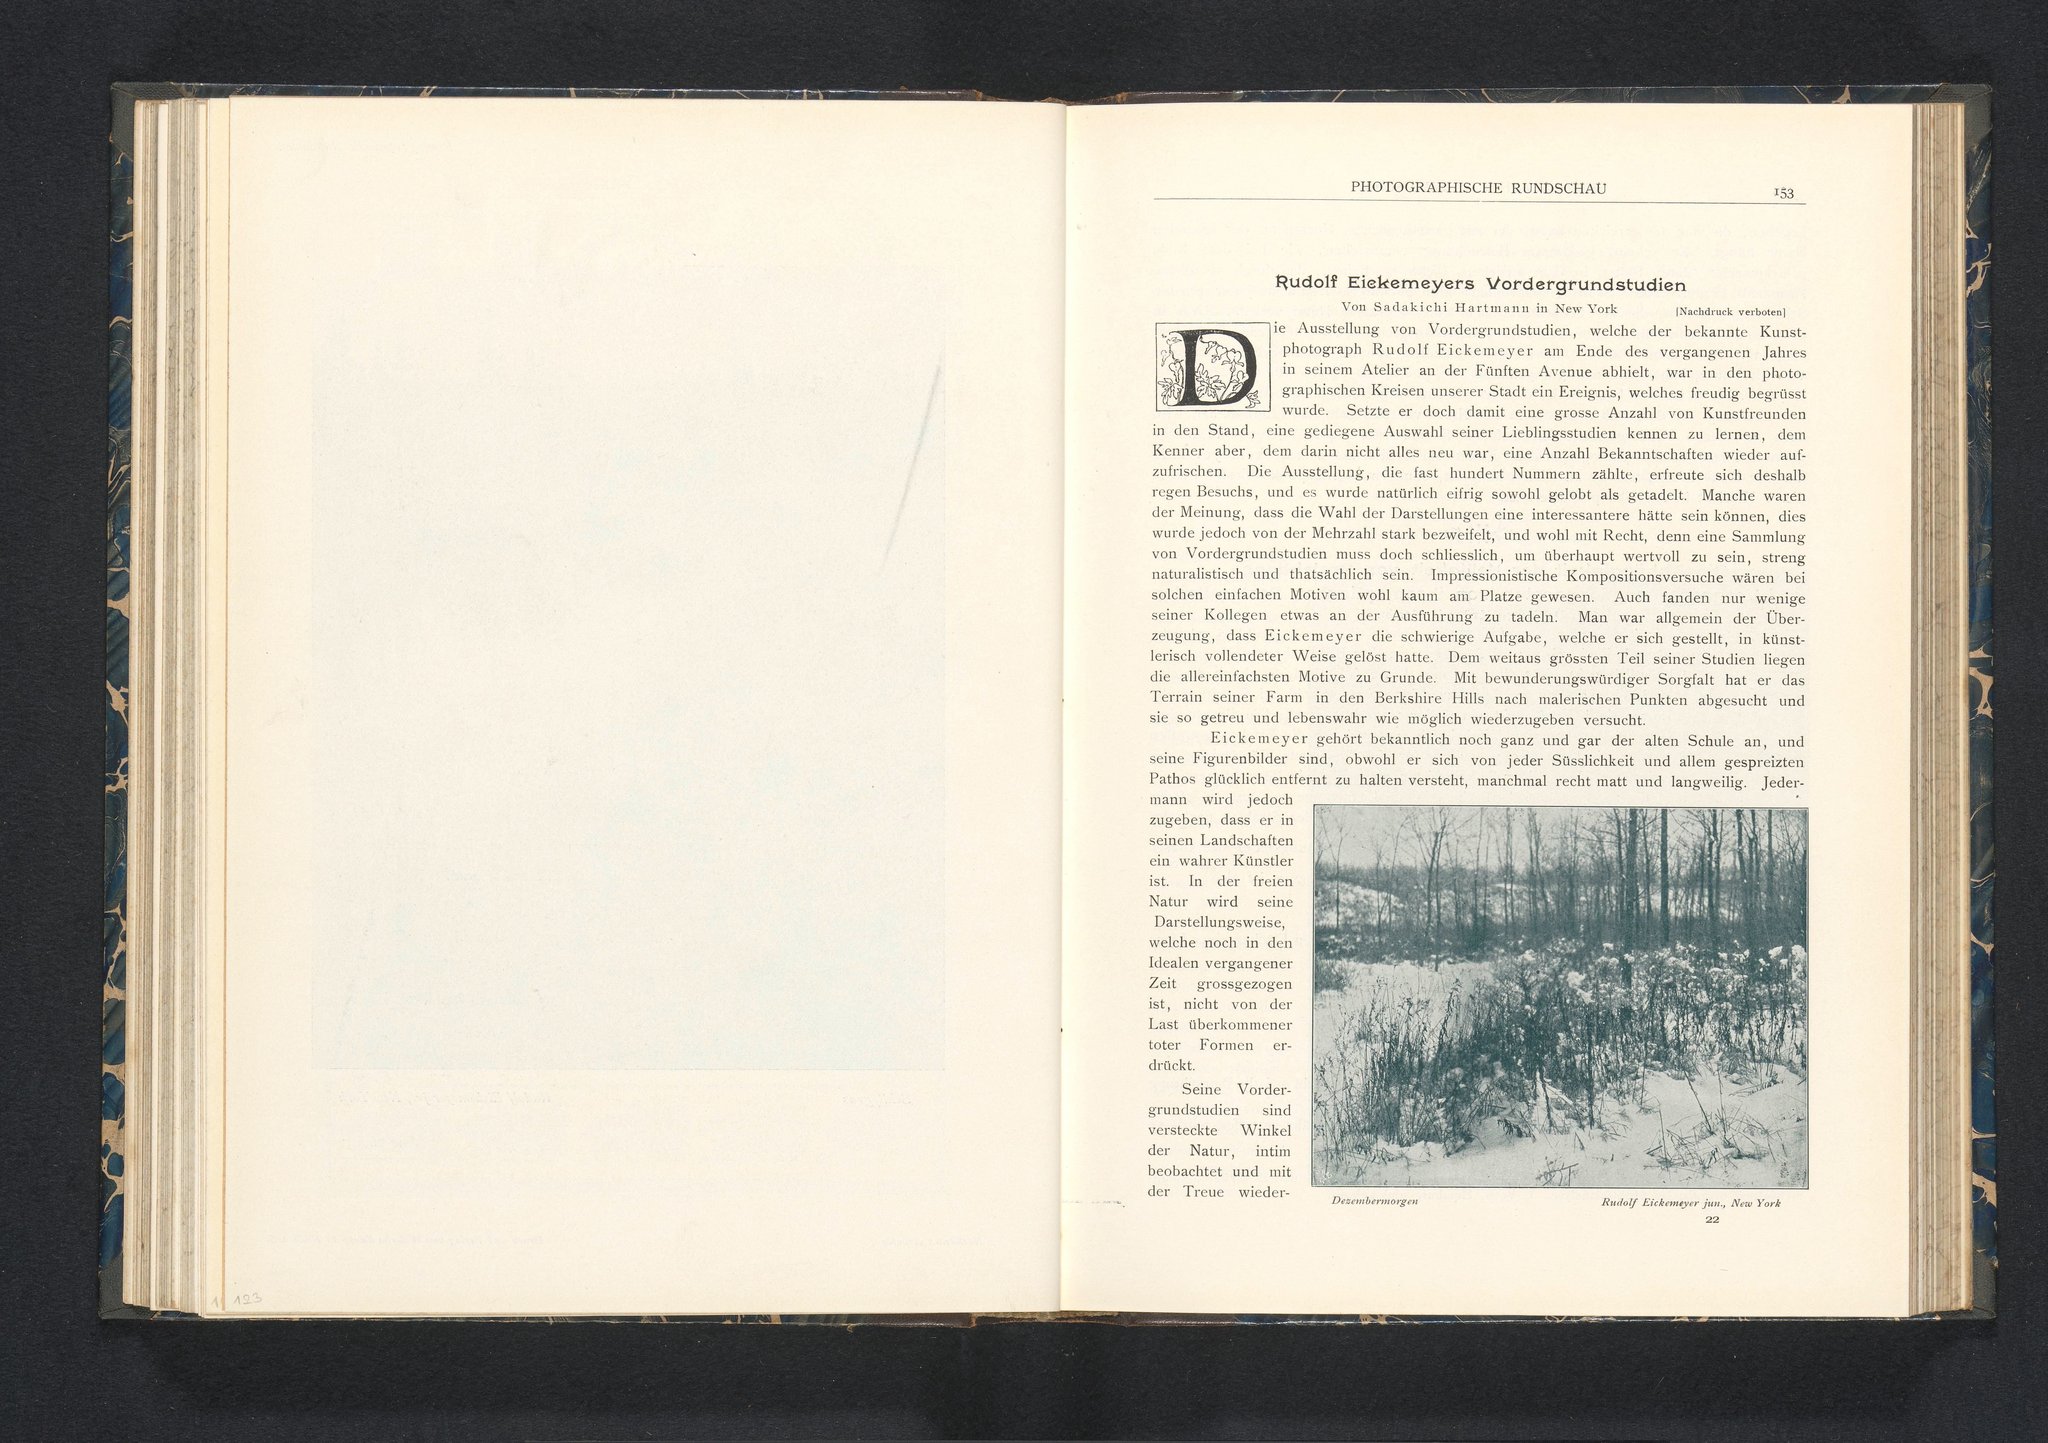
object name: photomechanical print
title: Dezembermorgen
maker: rudolf eickemeyer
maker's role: fotograaf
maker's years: 1862-1932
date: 1896-1901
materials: paper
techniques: autotype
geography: berlin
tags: landscapes, snow